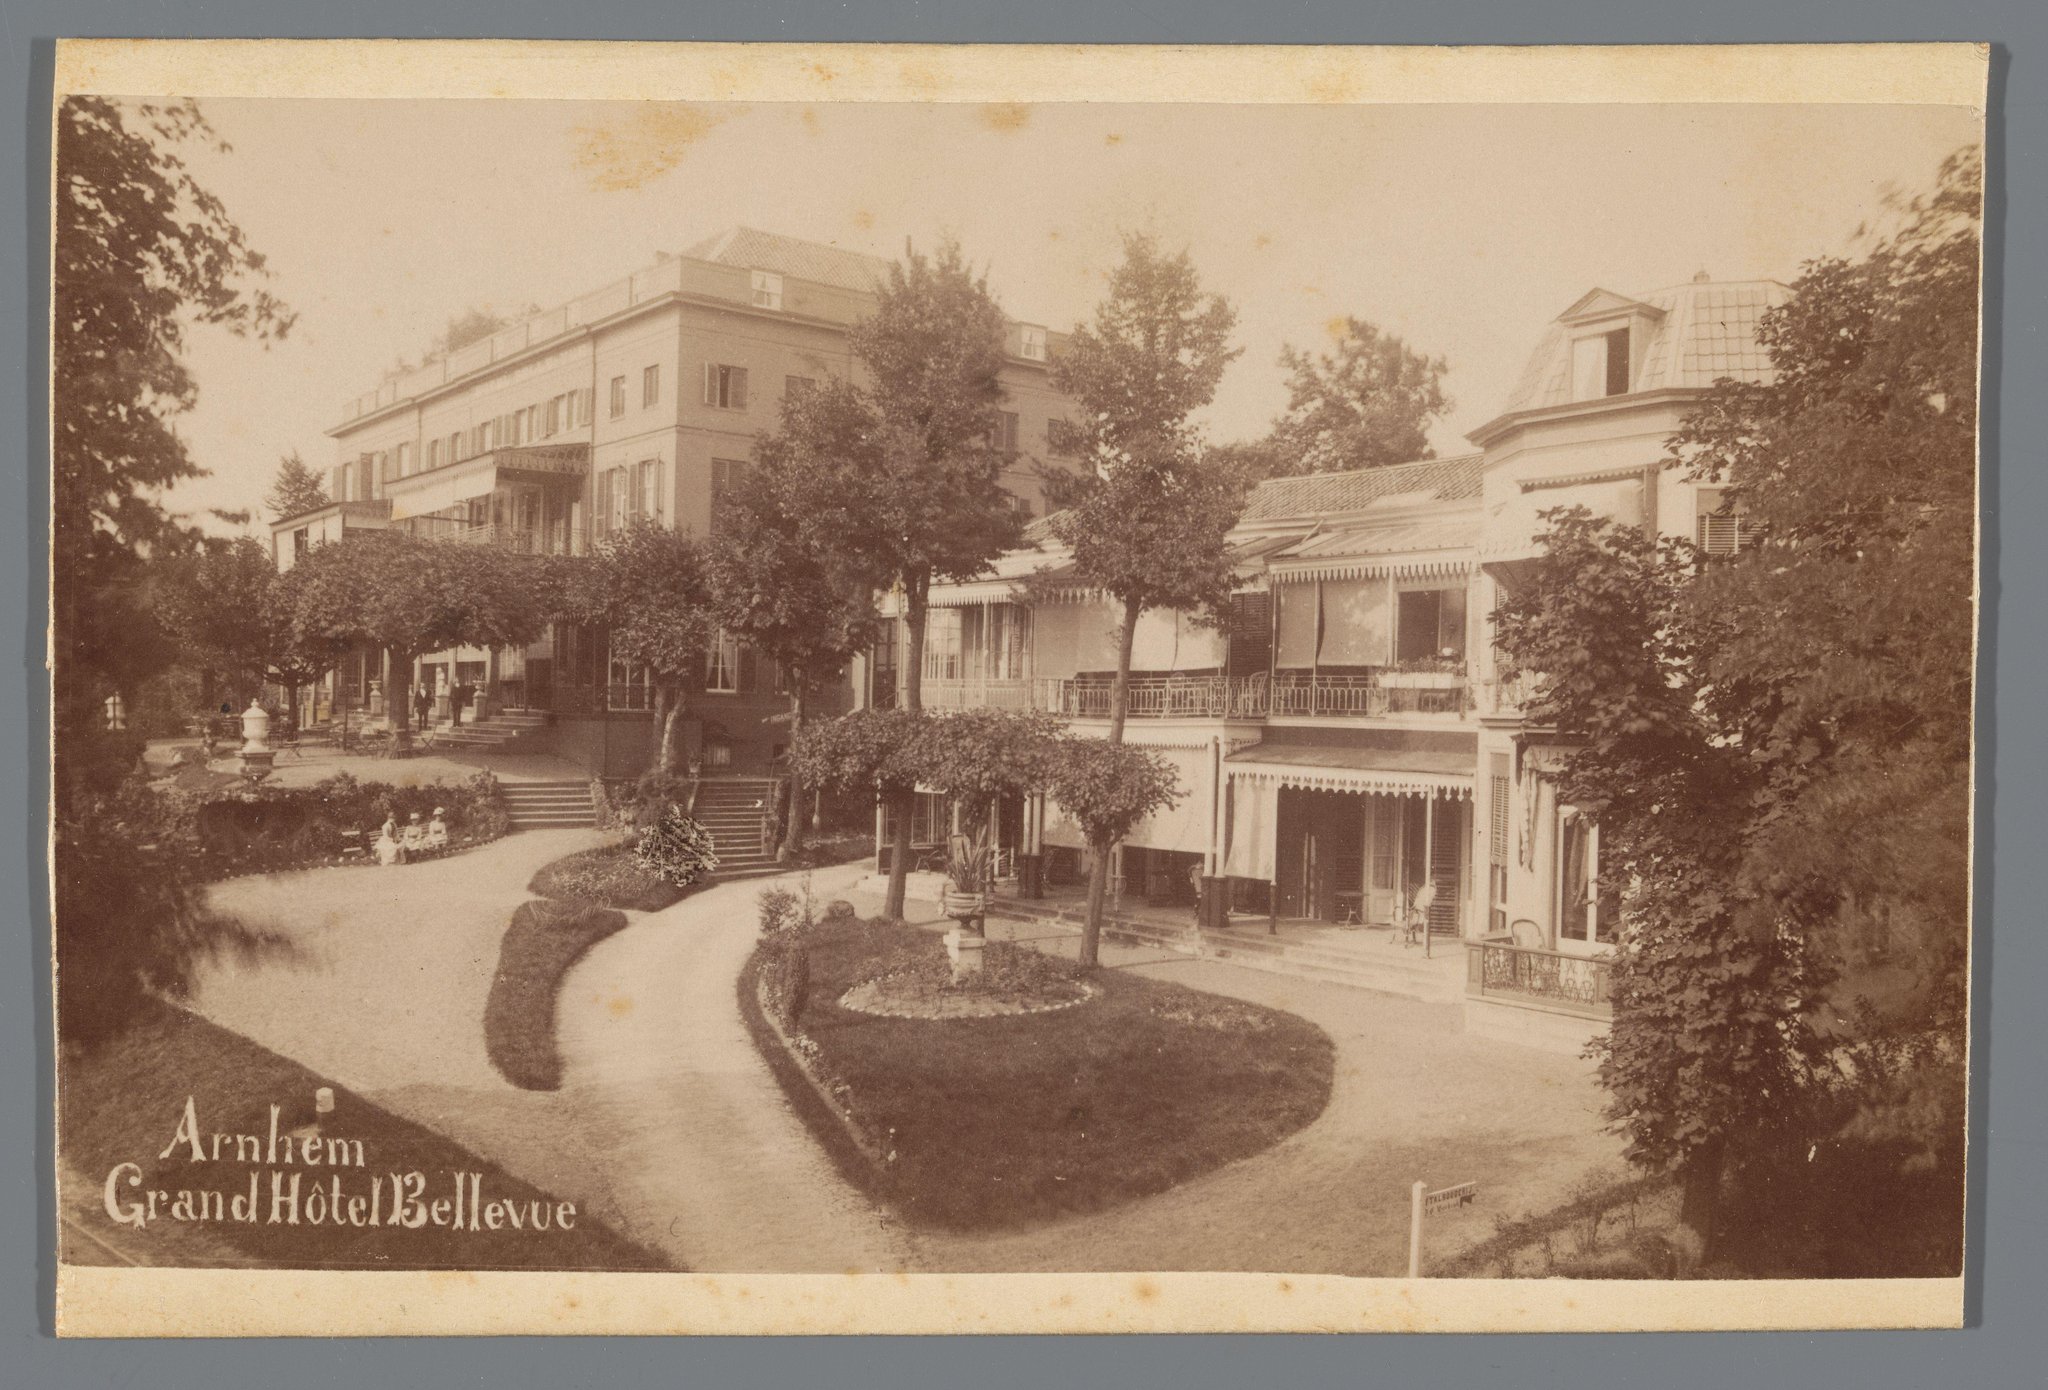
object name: photograph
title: Grand Hotel Bellevue te Arnhem, met op achterzijde menukaart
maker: Anonymous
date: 1895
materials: cardboard, paper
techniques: albumen print, letterpress printing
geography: arnhem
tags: hotel room, arnhem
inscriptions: inscription: ‘Arnhem/ Grand Hôtel Bellevue’, inscription: ‘Menu/ 21 Août 1895/ (...)’